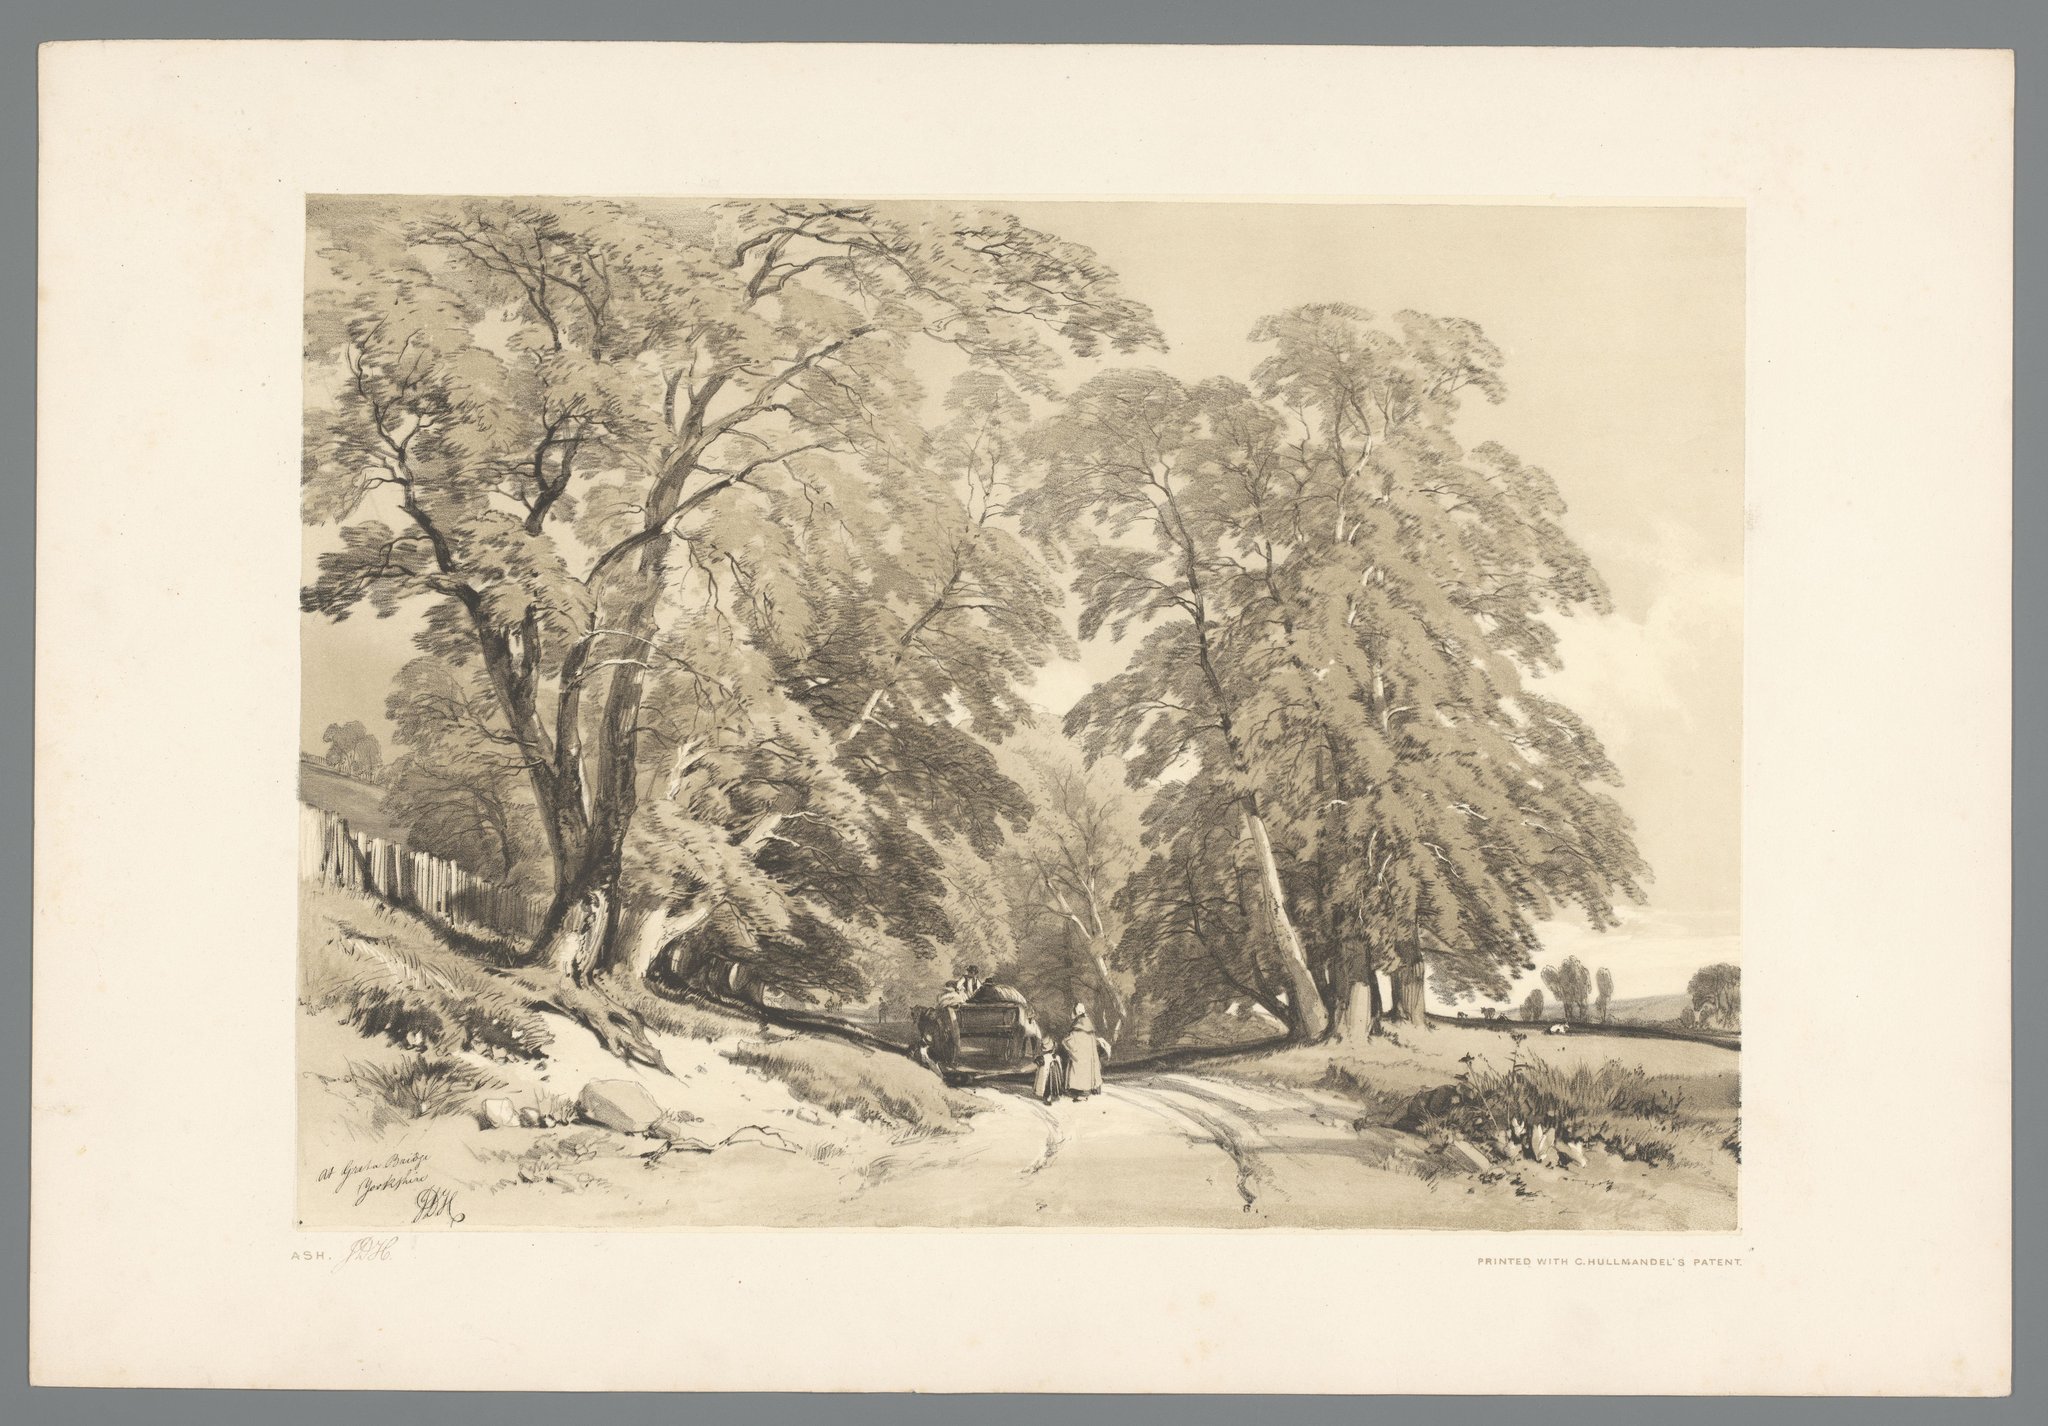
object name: print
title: The Park and the Forest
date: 1841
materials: paper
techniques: tone lithography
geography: london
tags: park, forest, wood, forest path or lane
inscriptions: : ‘At Greta Bridge, Yorkshire’, collector's mark: Lugt 2228, collector's mark: Lugt 2760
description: Prent maakt deel uit van een serie van 24 prenten.